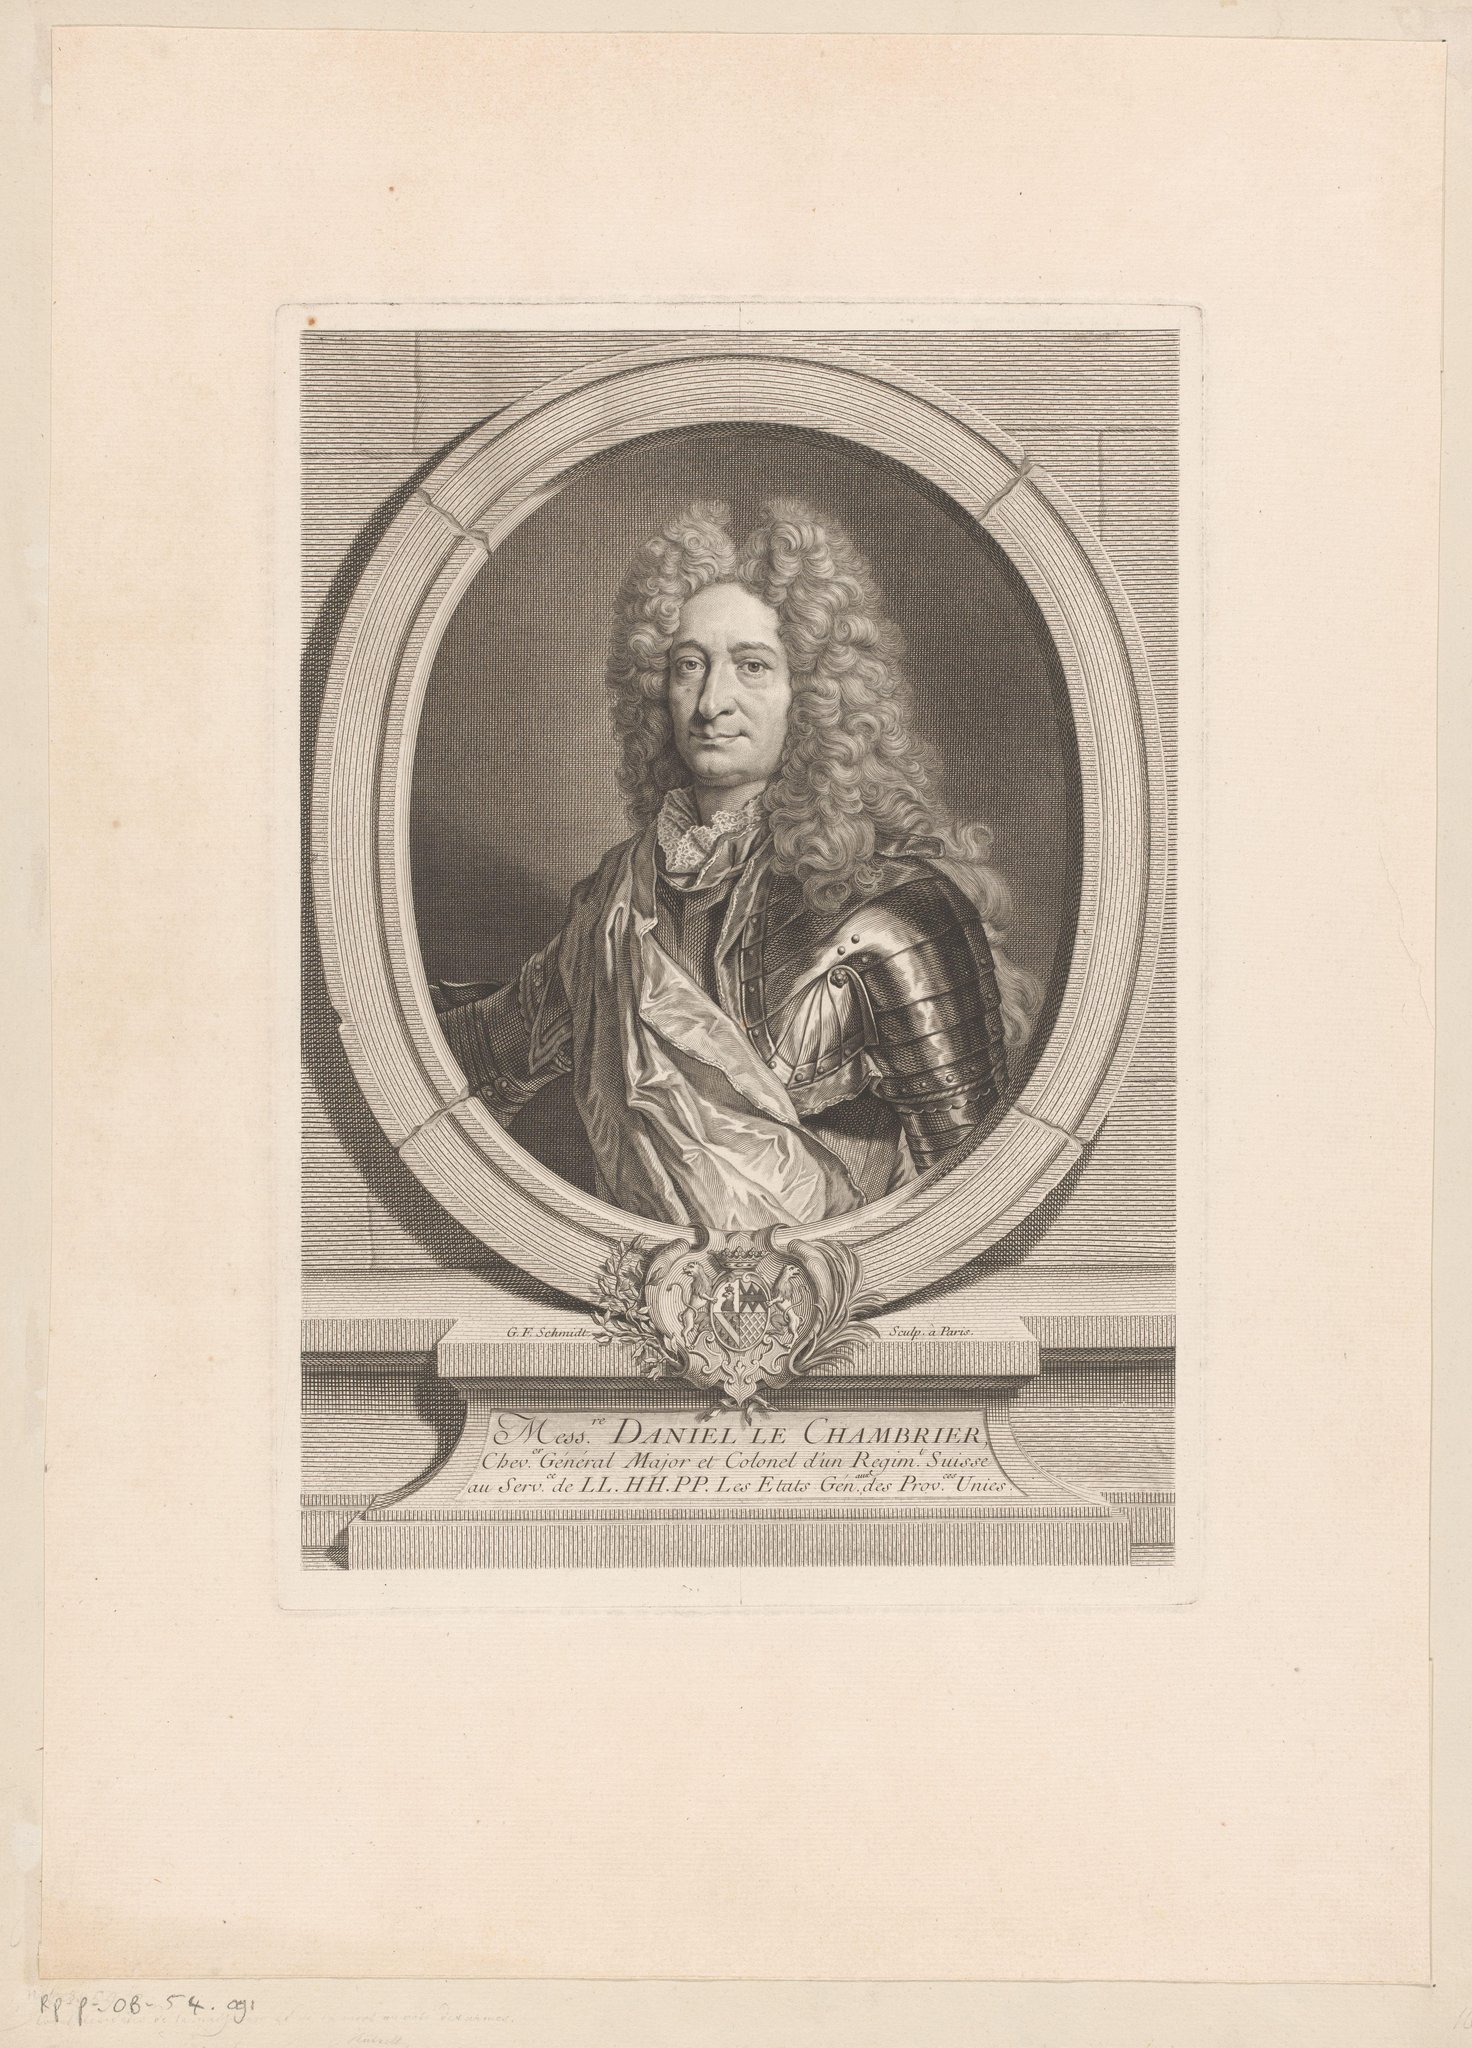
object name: print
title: Portret van Daniel de Chambrier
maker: georg friedrich schmidt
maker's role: draughtsman, print maker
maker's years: 1712-1775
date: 1722-1775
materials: paper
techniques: engraving, etching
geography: paris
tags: den bosch, lord, politician, historical persons, armorial bearing, heraldry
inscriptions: collector's mark: Lugt 240